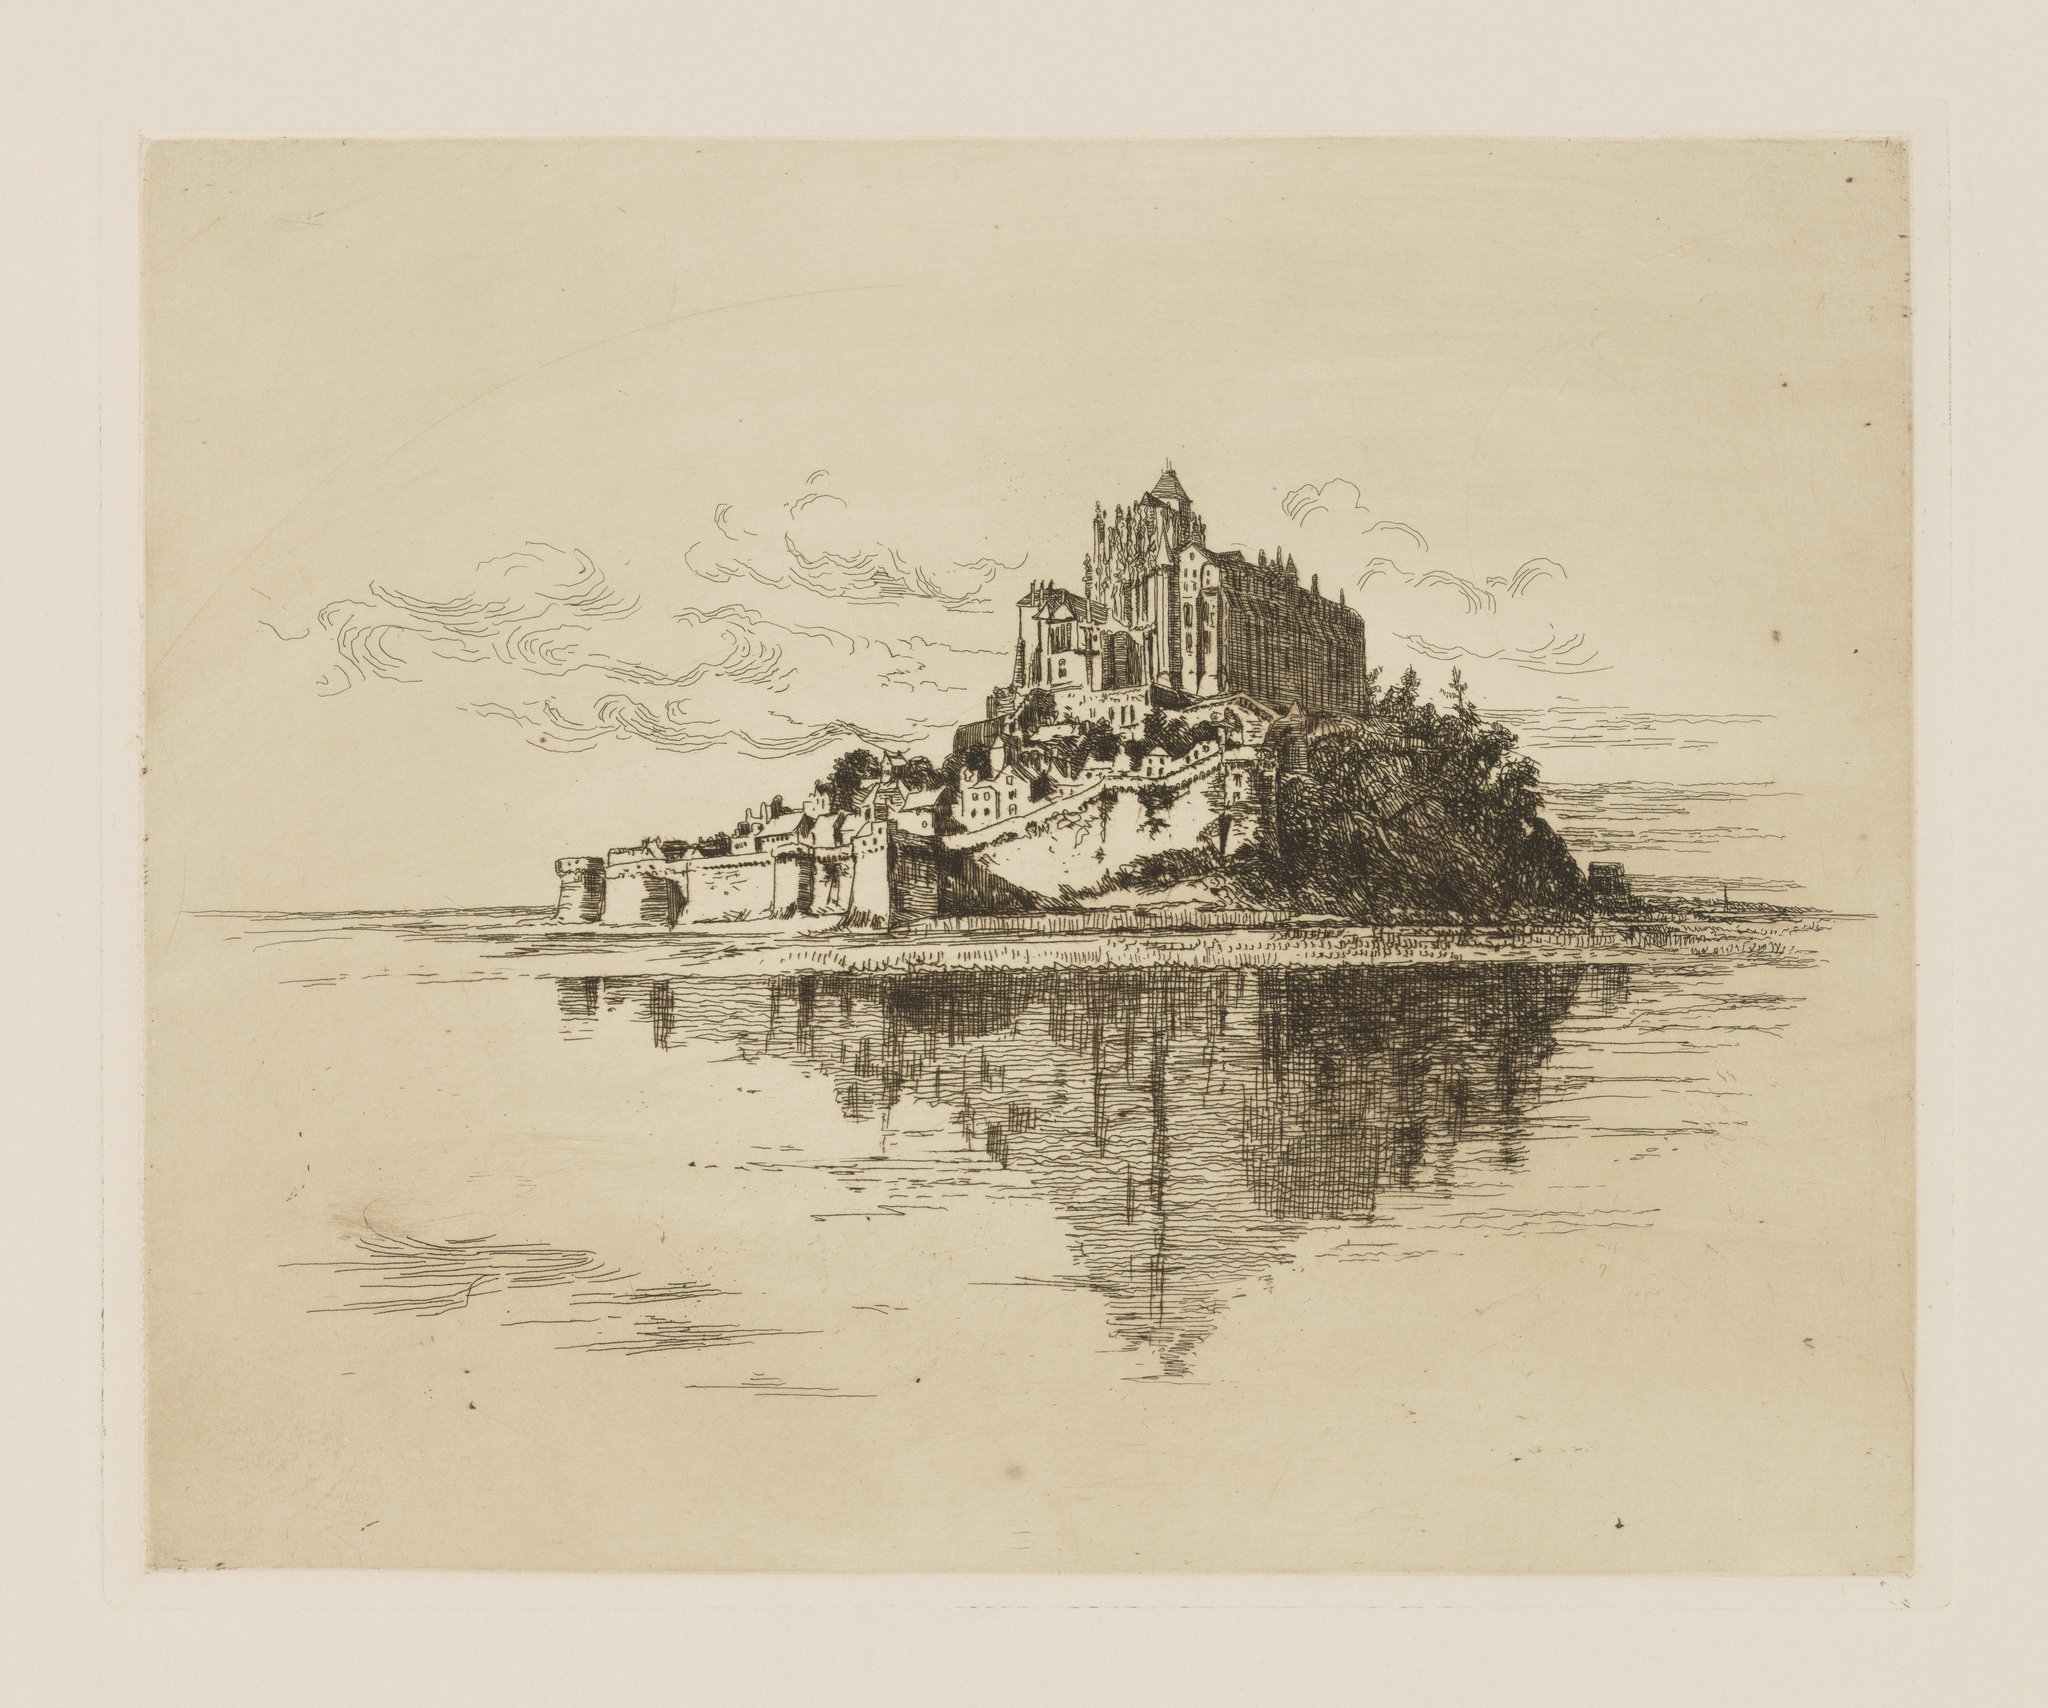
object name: print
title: Mont St. Michel, Brittany, France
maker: eliza pratt greatorex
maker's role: artist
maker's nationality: american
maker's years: 1819-1897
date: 1887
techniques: printmaking, etching